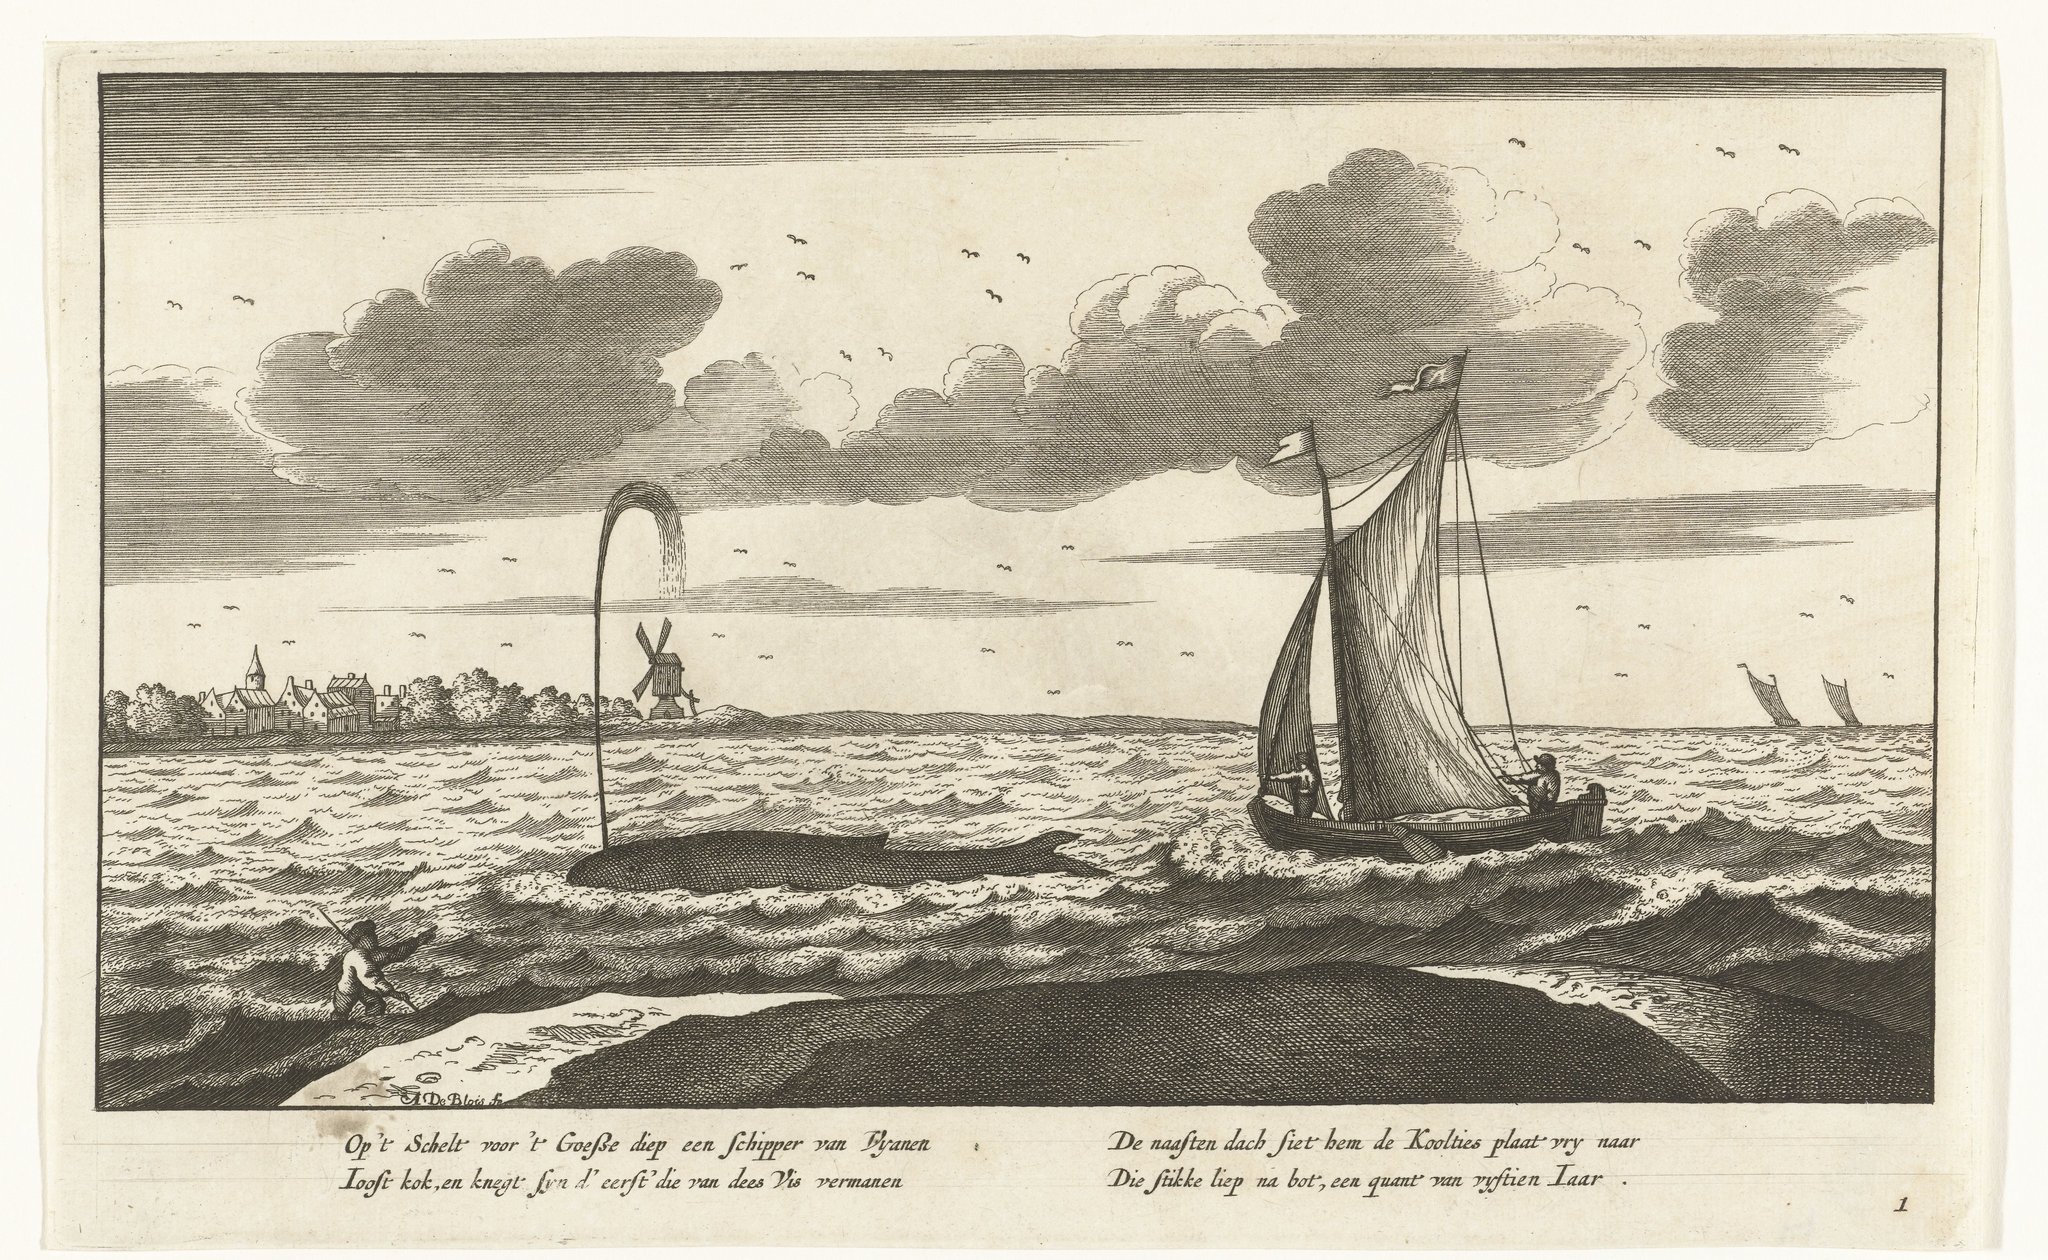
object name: print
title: Zes prenten van het vangen van een walvis bij Sint Annaland in 1682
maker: abraham de blois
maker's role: print maker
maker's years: 1679-1717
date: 1682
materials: paper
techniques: etching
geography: northern netherlands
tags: whale fishery, whaling, swimming mammals: whale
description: De visser Joost Kok uit Vianen ontdekt de walvis. In het onderschrift een vers van 4 regels. Prent nr. 1 in een serie van zes prenten over het vangen van een walvis bij Sint Annaland op het eiland Tholen, 7 oktober 1682.